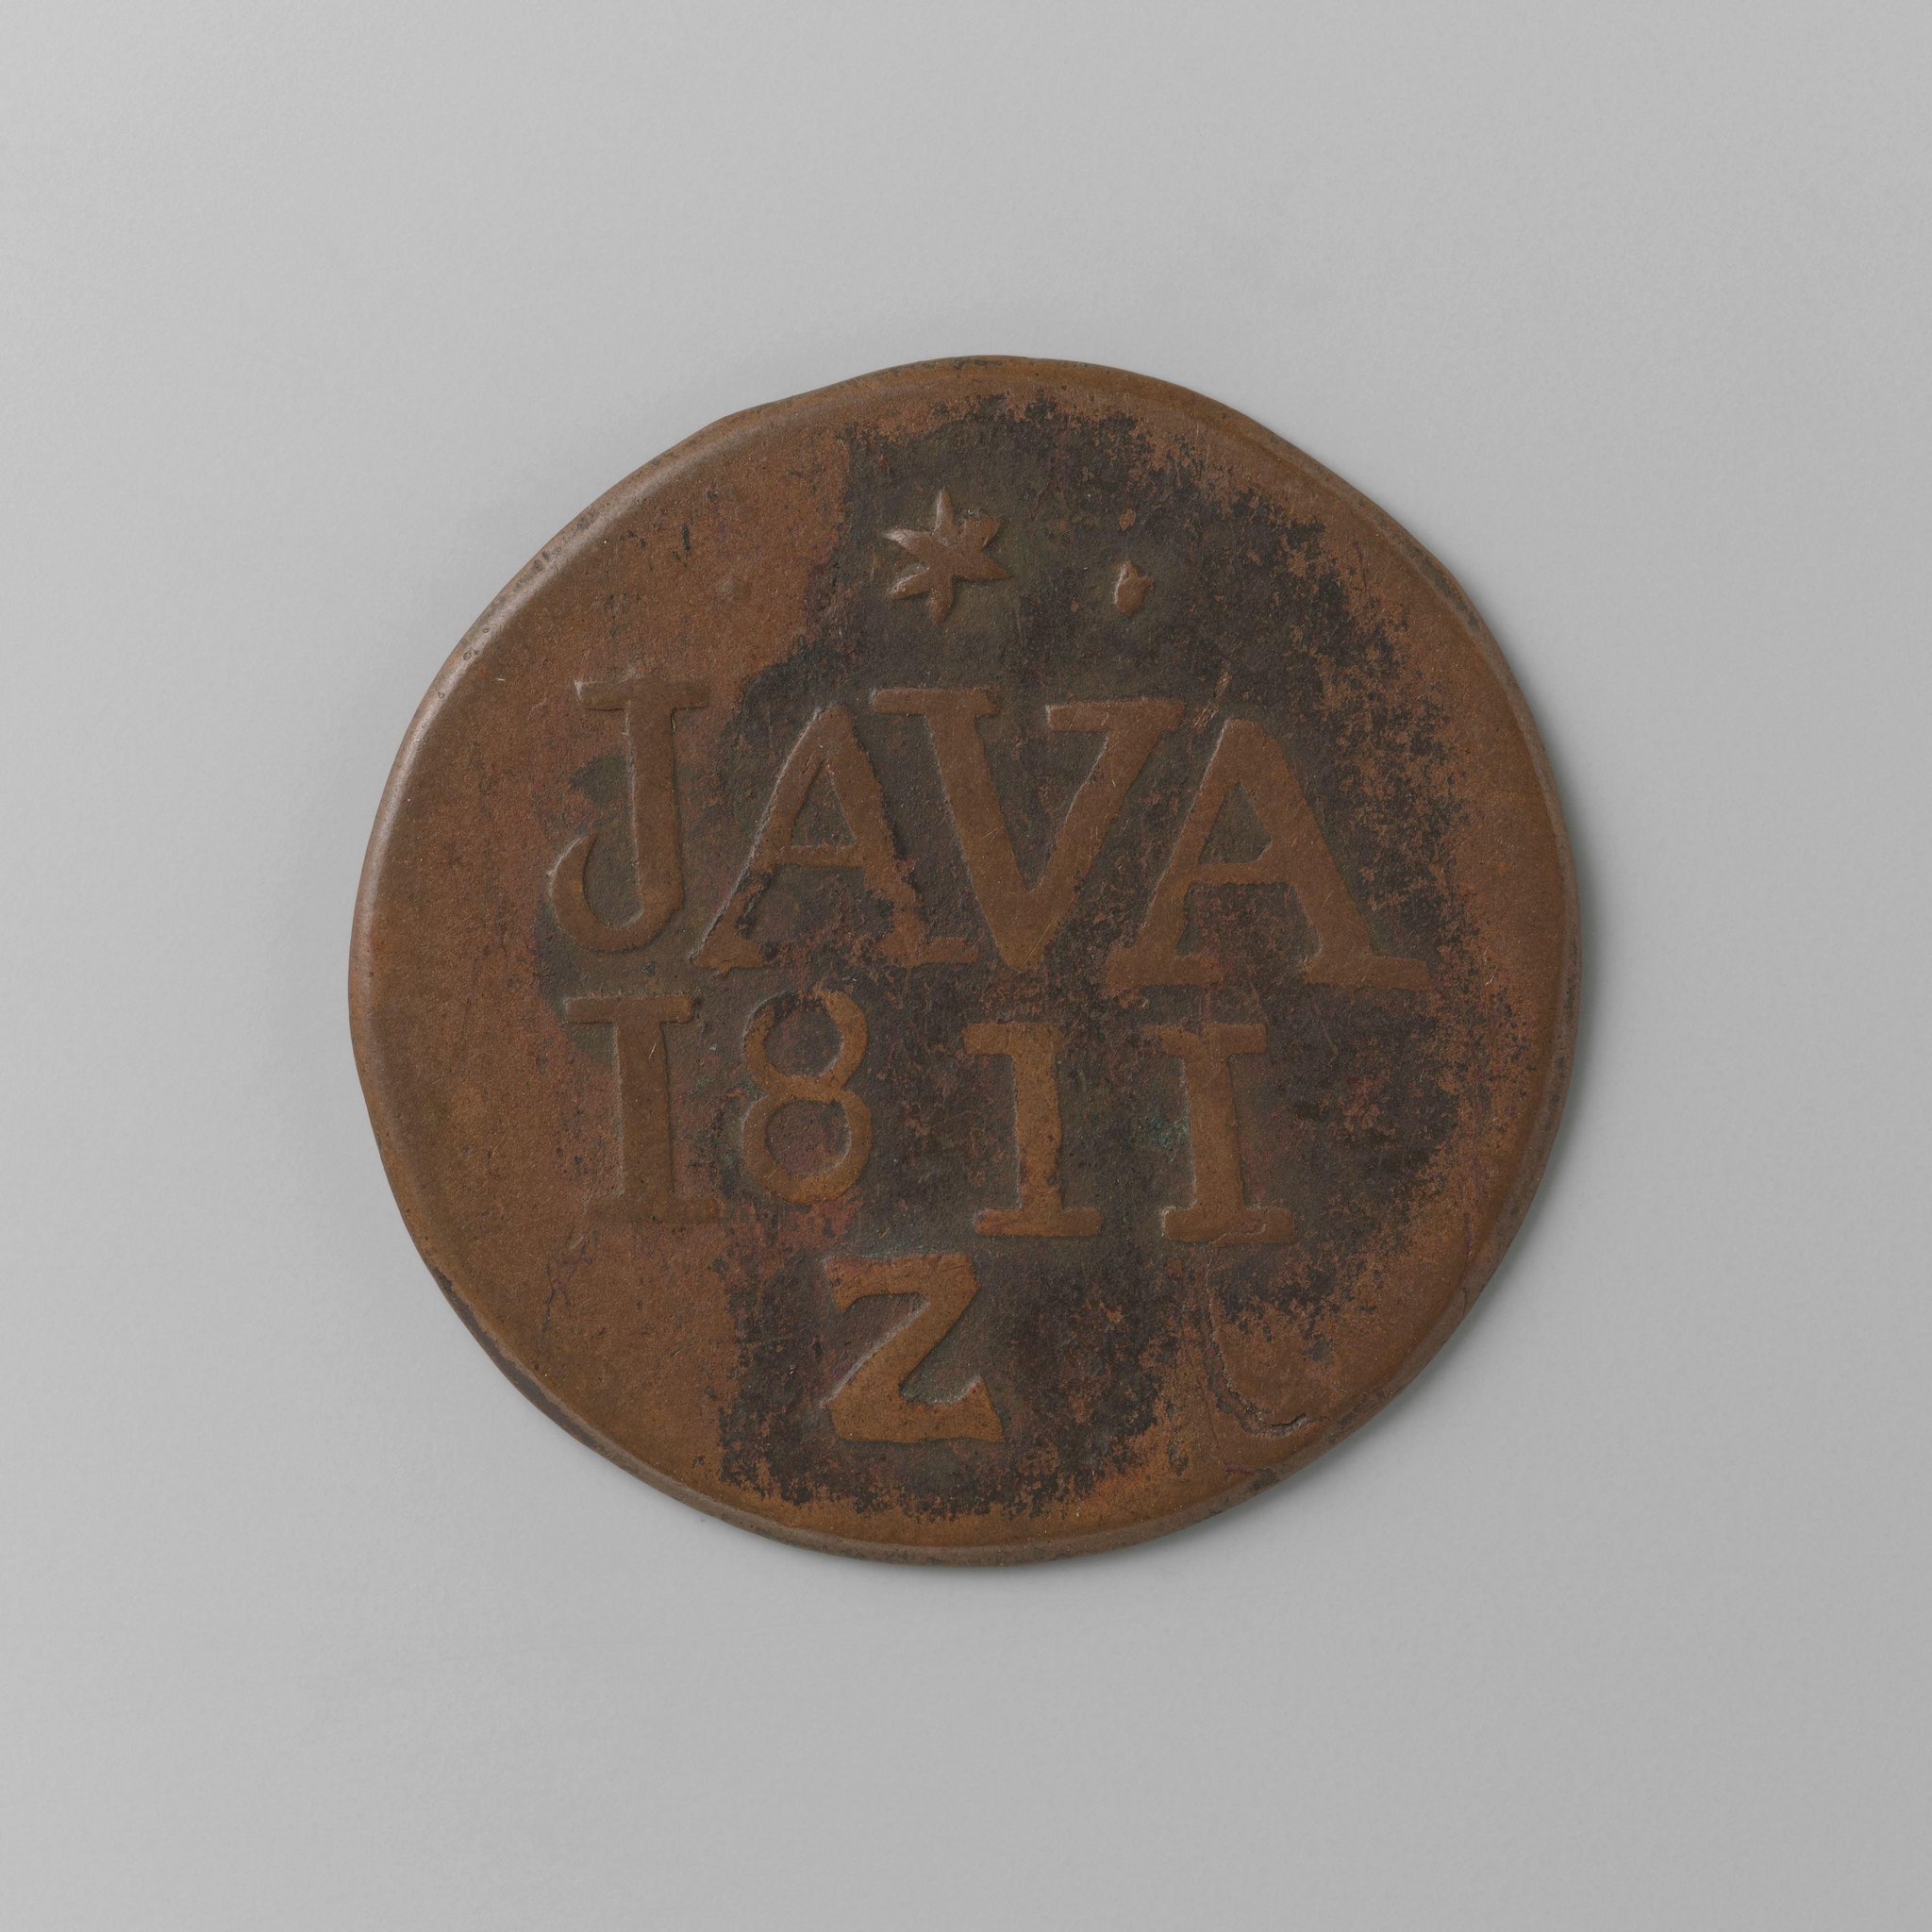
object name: coin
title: Duit voor Nederlands Indië uit Java,1811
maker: napoleon i (emperor of the french)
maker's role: generaal, keizer, staatsman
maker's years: 1769-1821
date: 1811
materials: copper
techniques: striking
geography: surabaya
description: Koperen munt. Voorzijde: initialen L en N van Lodewijk Napoleon. Daarboven muntteken. Keerzijde: eenregelig opschrift, waaronder jaartal. Boven opschrift muntteken en onder jaartal muntmeesterteken Z [=muntmeester Zwekkert].